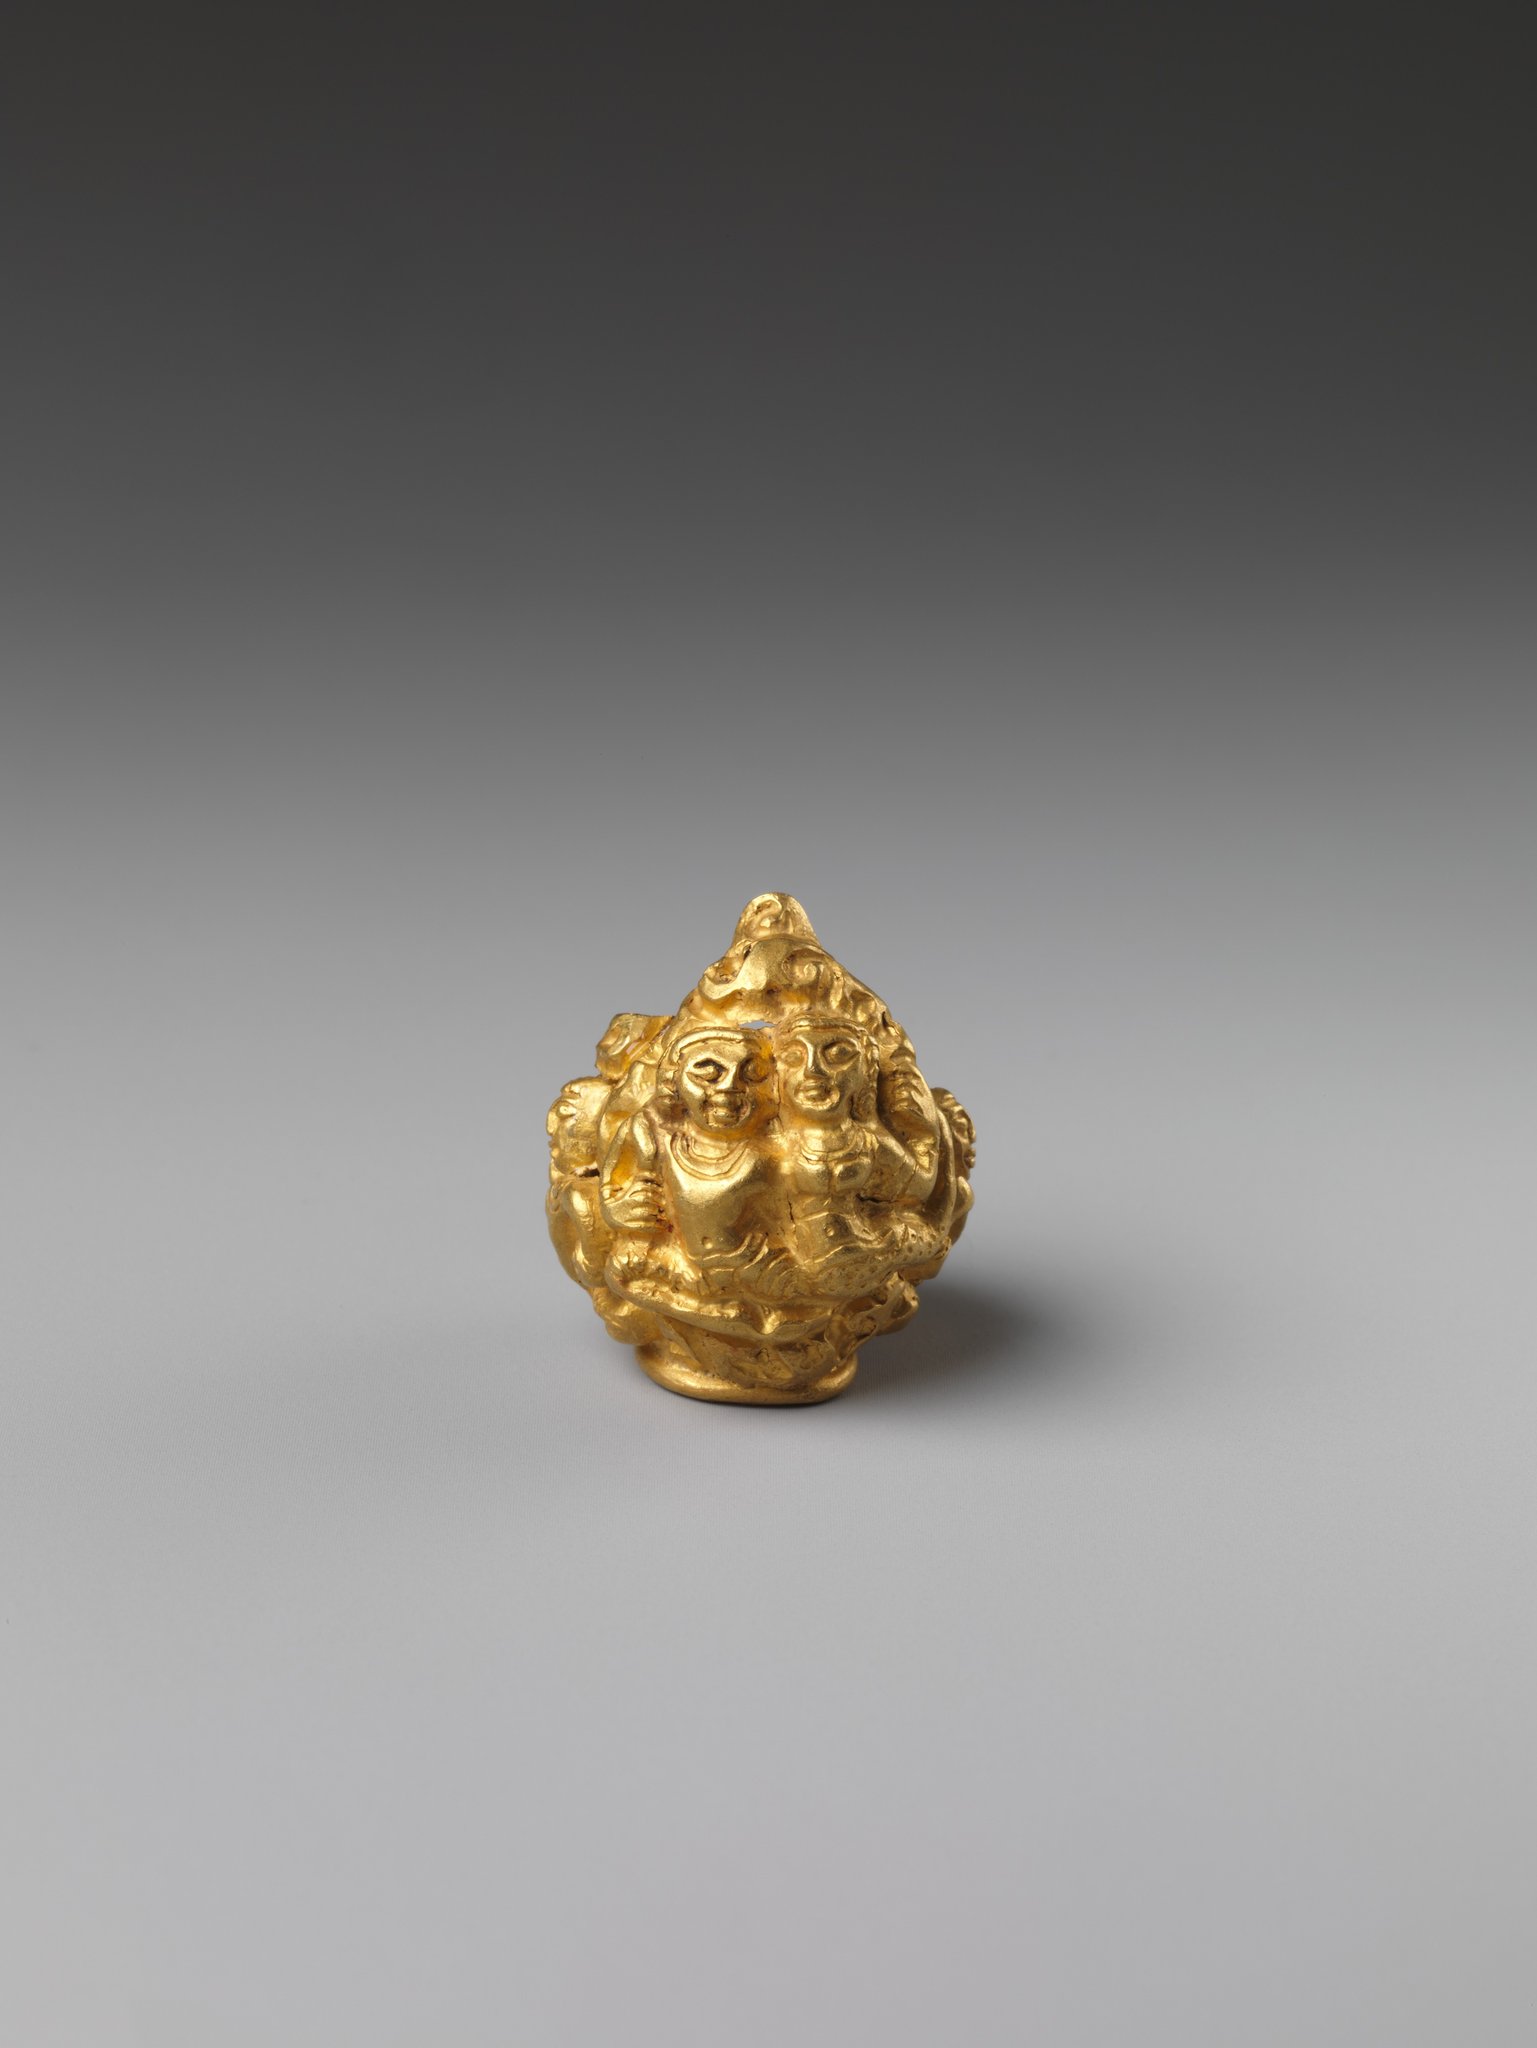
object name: finial clip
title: Rod Finial Clip with Deity Surrounded By Sekti Motif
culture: indonesian, javanese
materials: gold